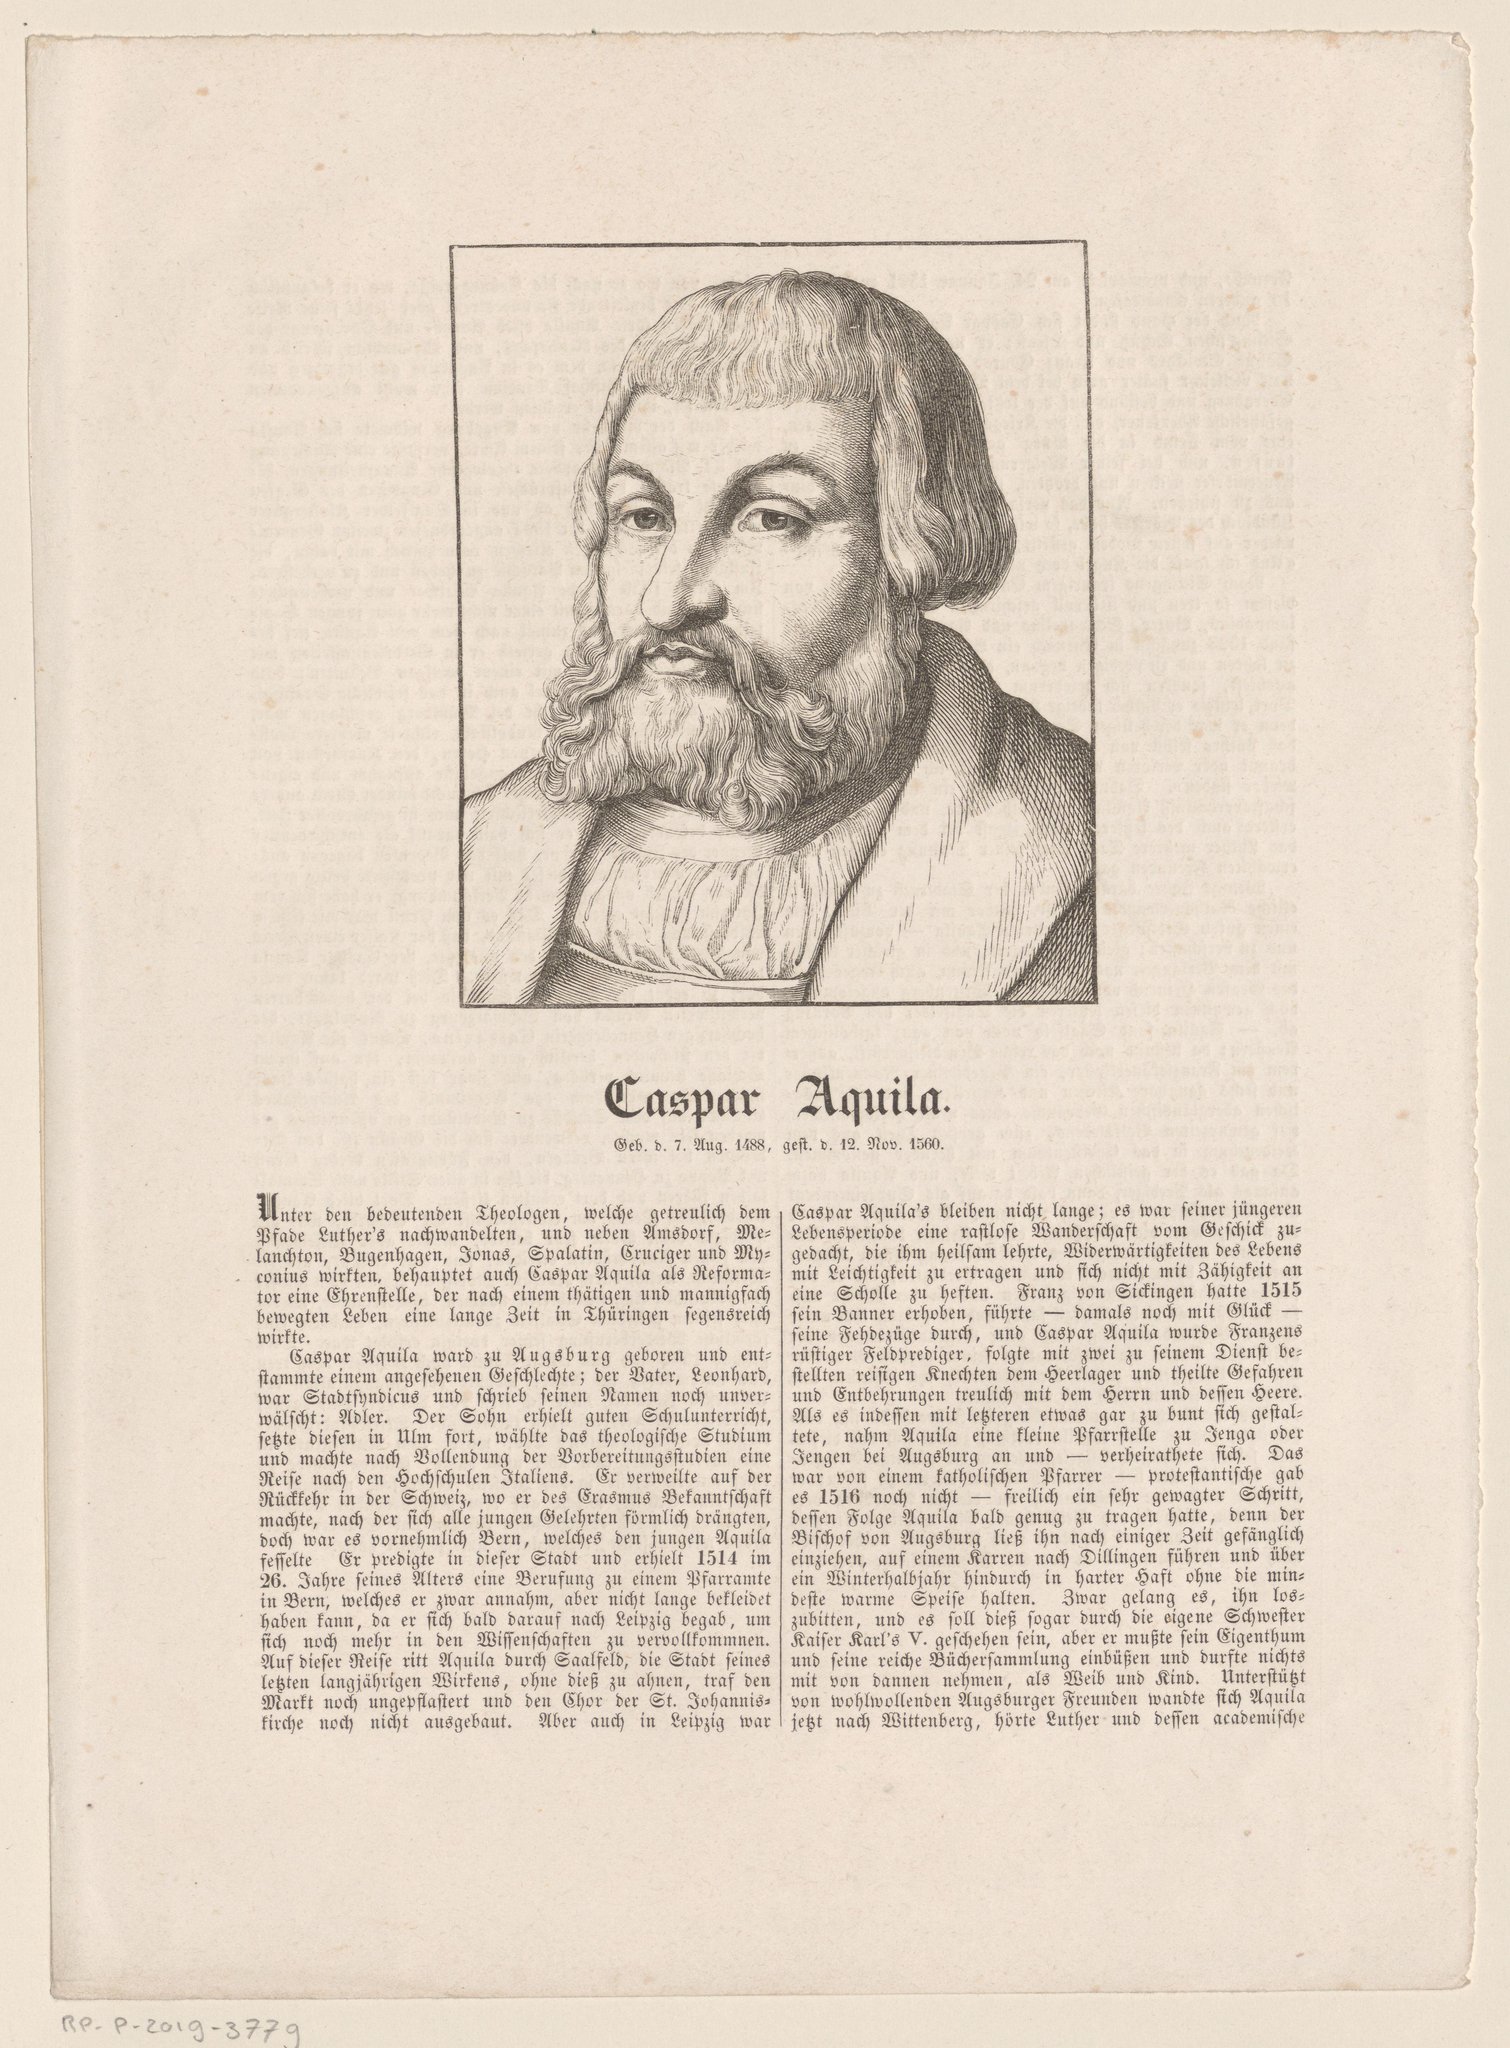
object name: print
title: Portret van Caspar Aquila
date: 1854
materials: paper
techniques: letterpress printing, engraving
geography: leipzig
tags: theologian, historical persons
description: Prent uit: Bechstein, Ludwig. Zweihundert deutsche Männer in Bildnissen und Lebensbeschreibungen. Leipzig: Georg Wigand, 1854.